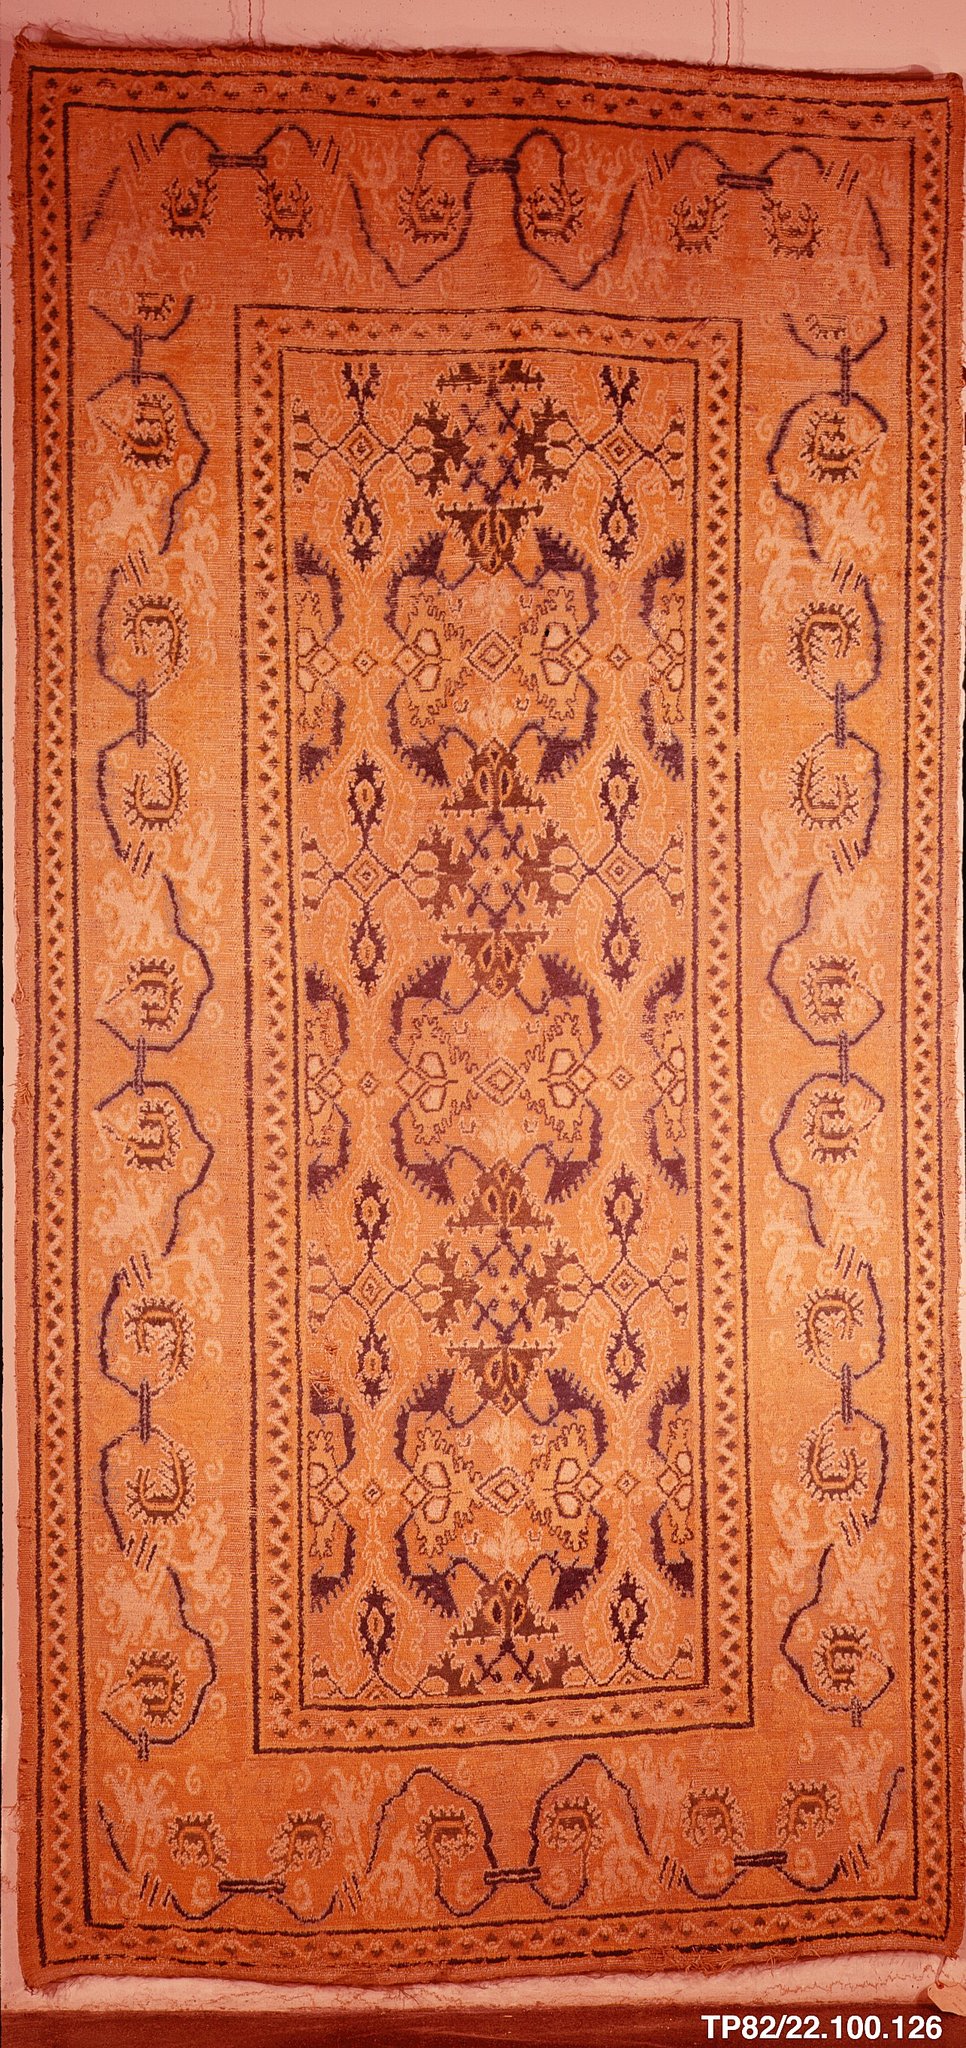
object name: carpet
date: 1601-1700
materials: linen, wool